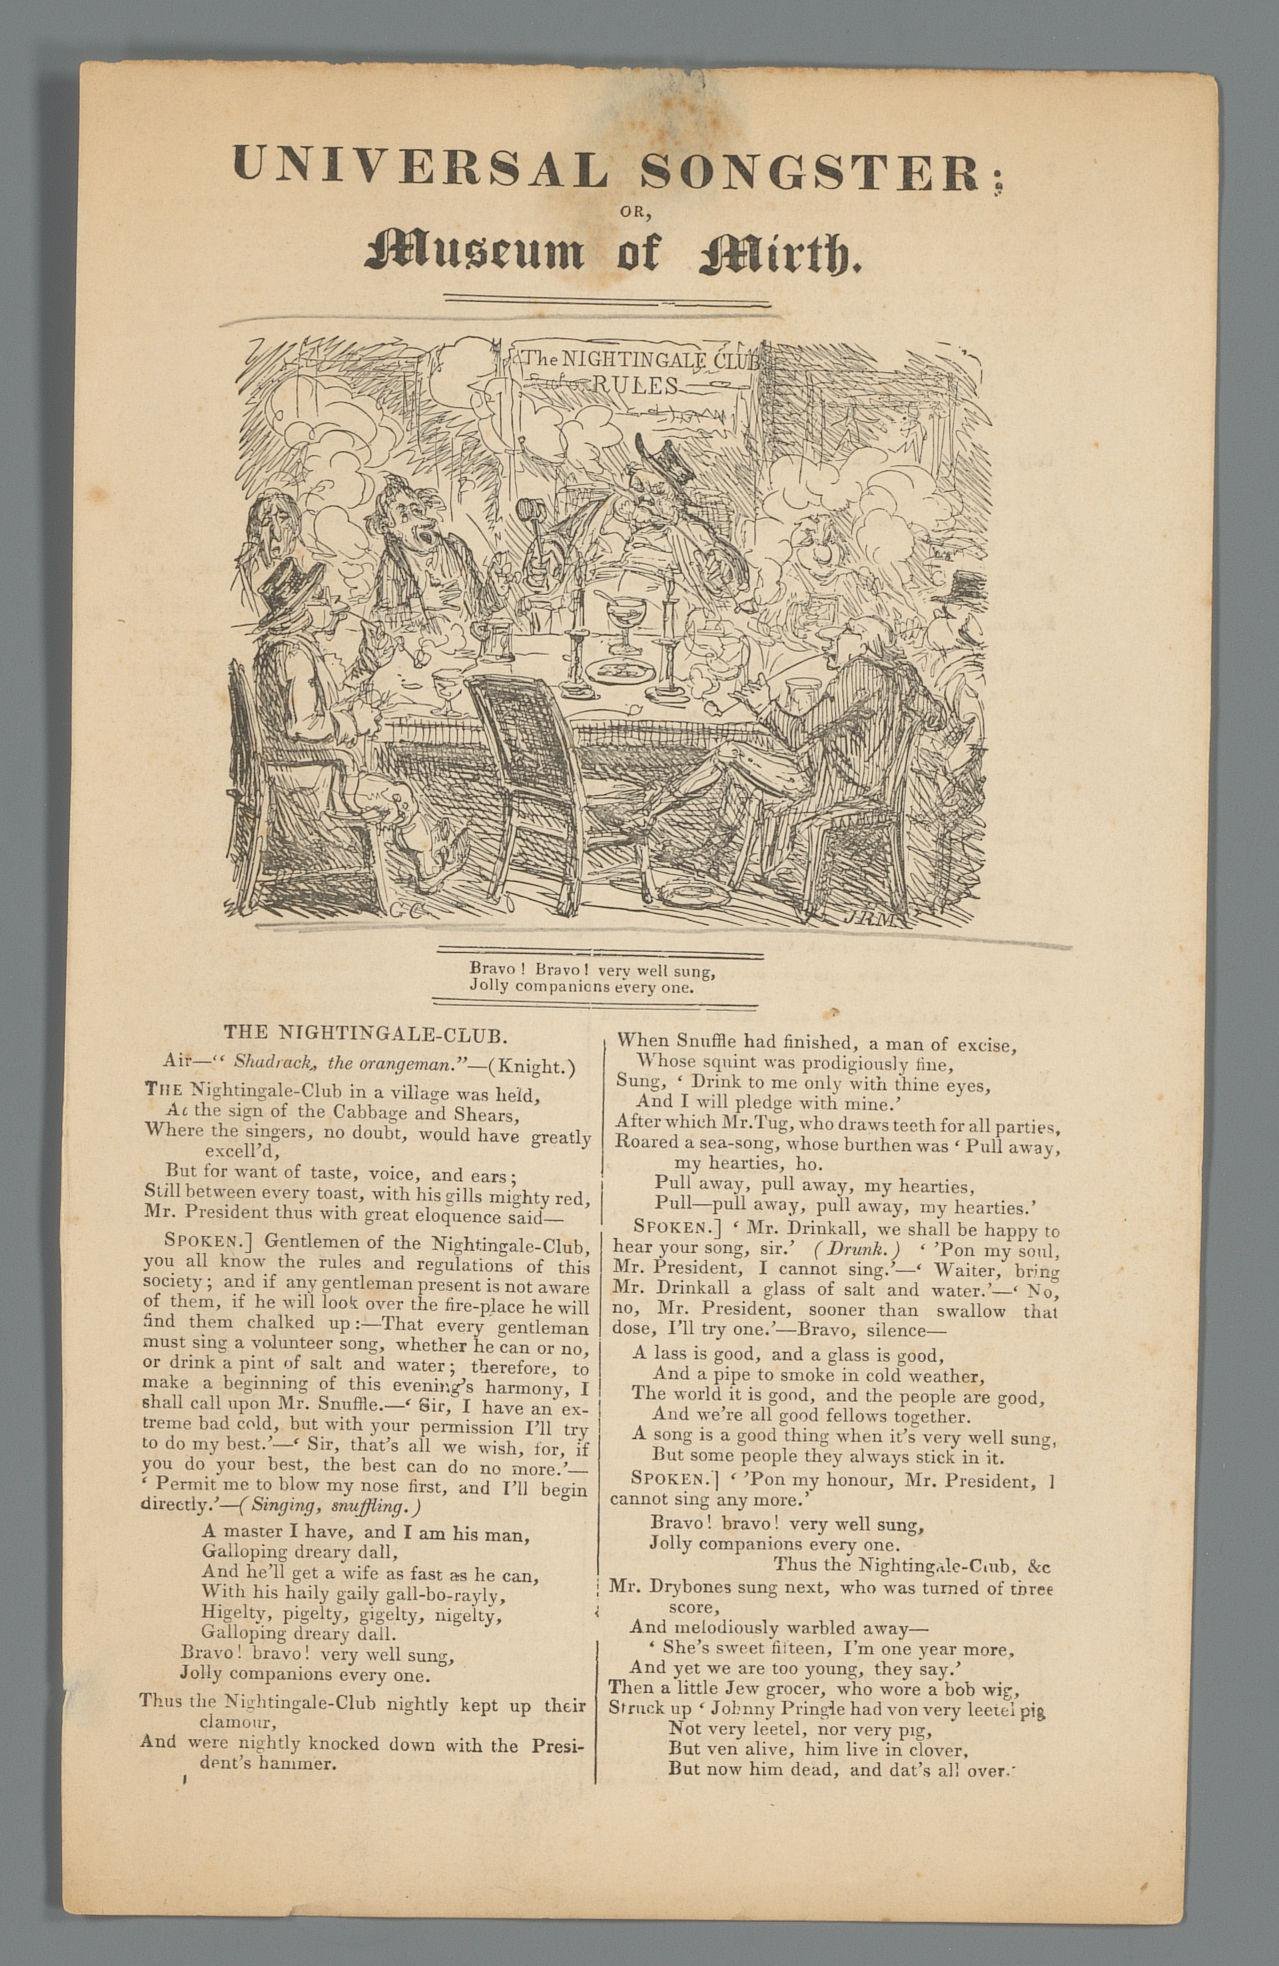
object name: cartoon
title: Spotprent bij het lied: The Nightingale-Club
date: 1825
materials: paper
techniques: engraving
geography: london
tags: inn, coffee-house, public house, etc., pipe ~ tobacco, vocal music, singing, political caricatures and satires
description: Herbergscène met rokende, drinkende en zingende lieden rond een tafel. Spotprent bij een blad met de tekst van het lied: The Nightingale-Club. Illustratie (p. 1/2) genomen uit een uitgave van de liederenbundel: The Universal Songster, or Museum of Mirth, vol. I., eerst verschenen in 1825.